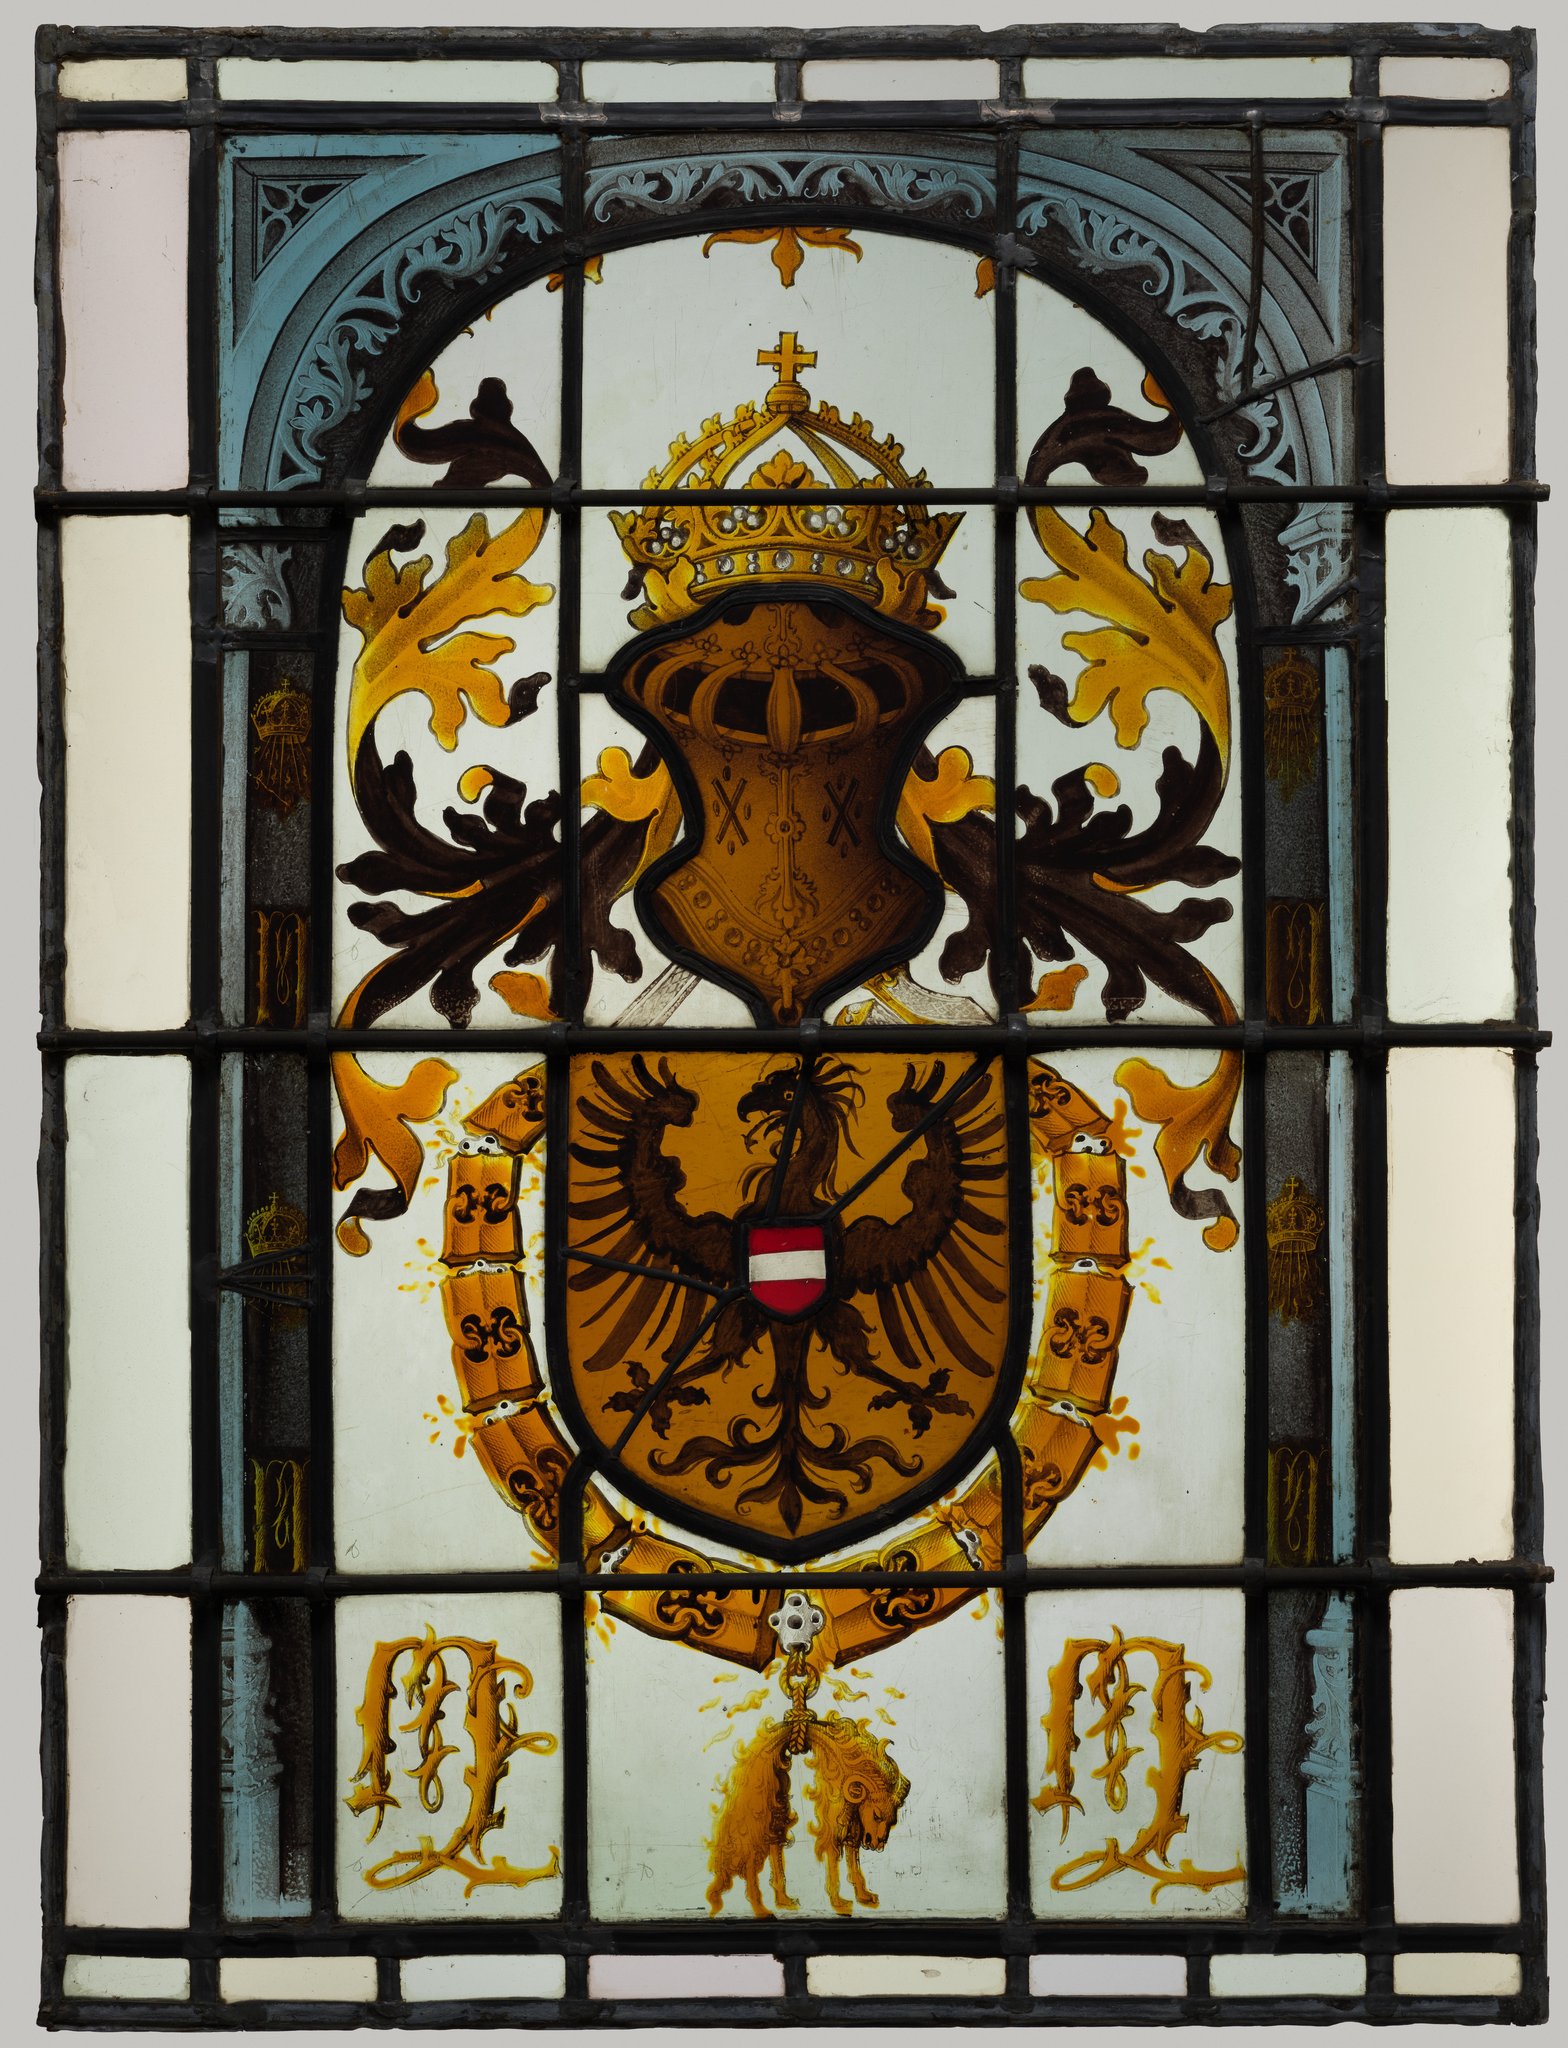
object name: panel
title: Heraldic Panel with Arms of the House of Hapsburg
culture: south netherlandish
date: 1504-1506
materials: glass, metal, paint, pigment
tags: coat of arms